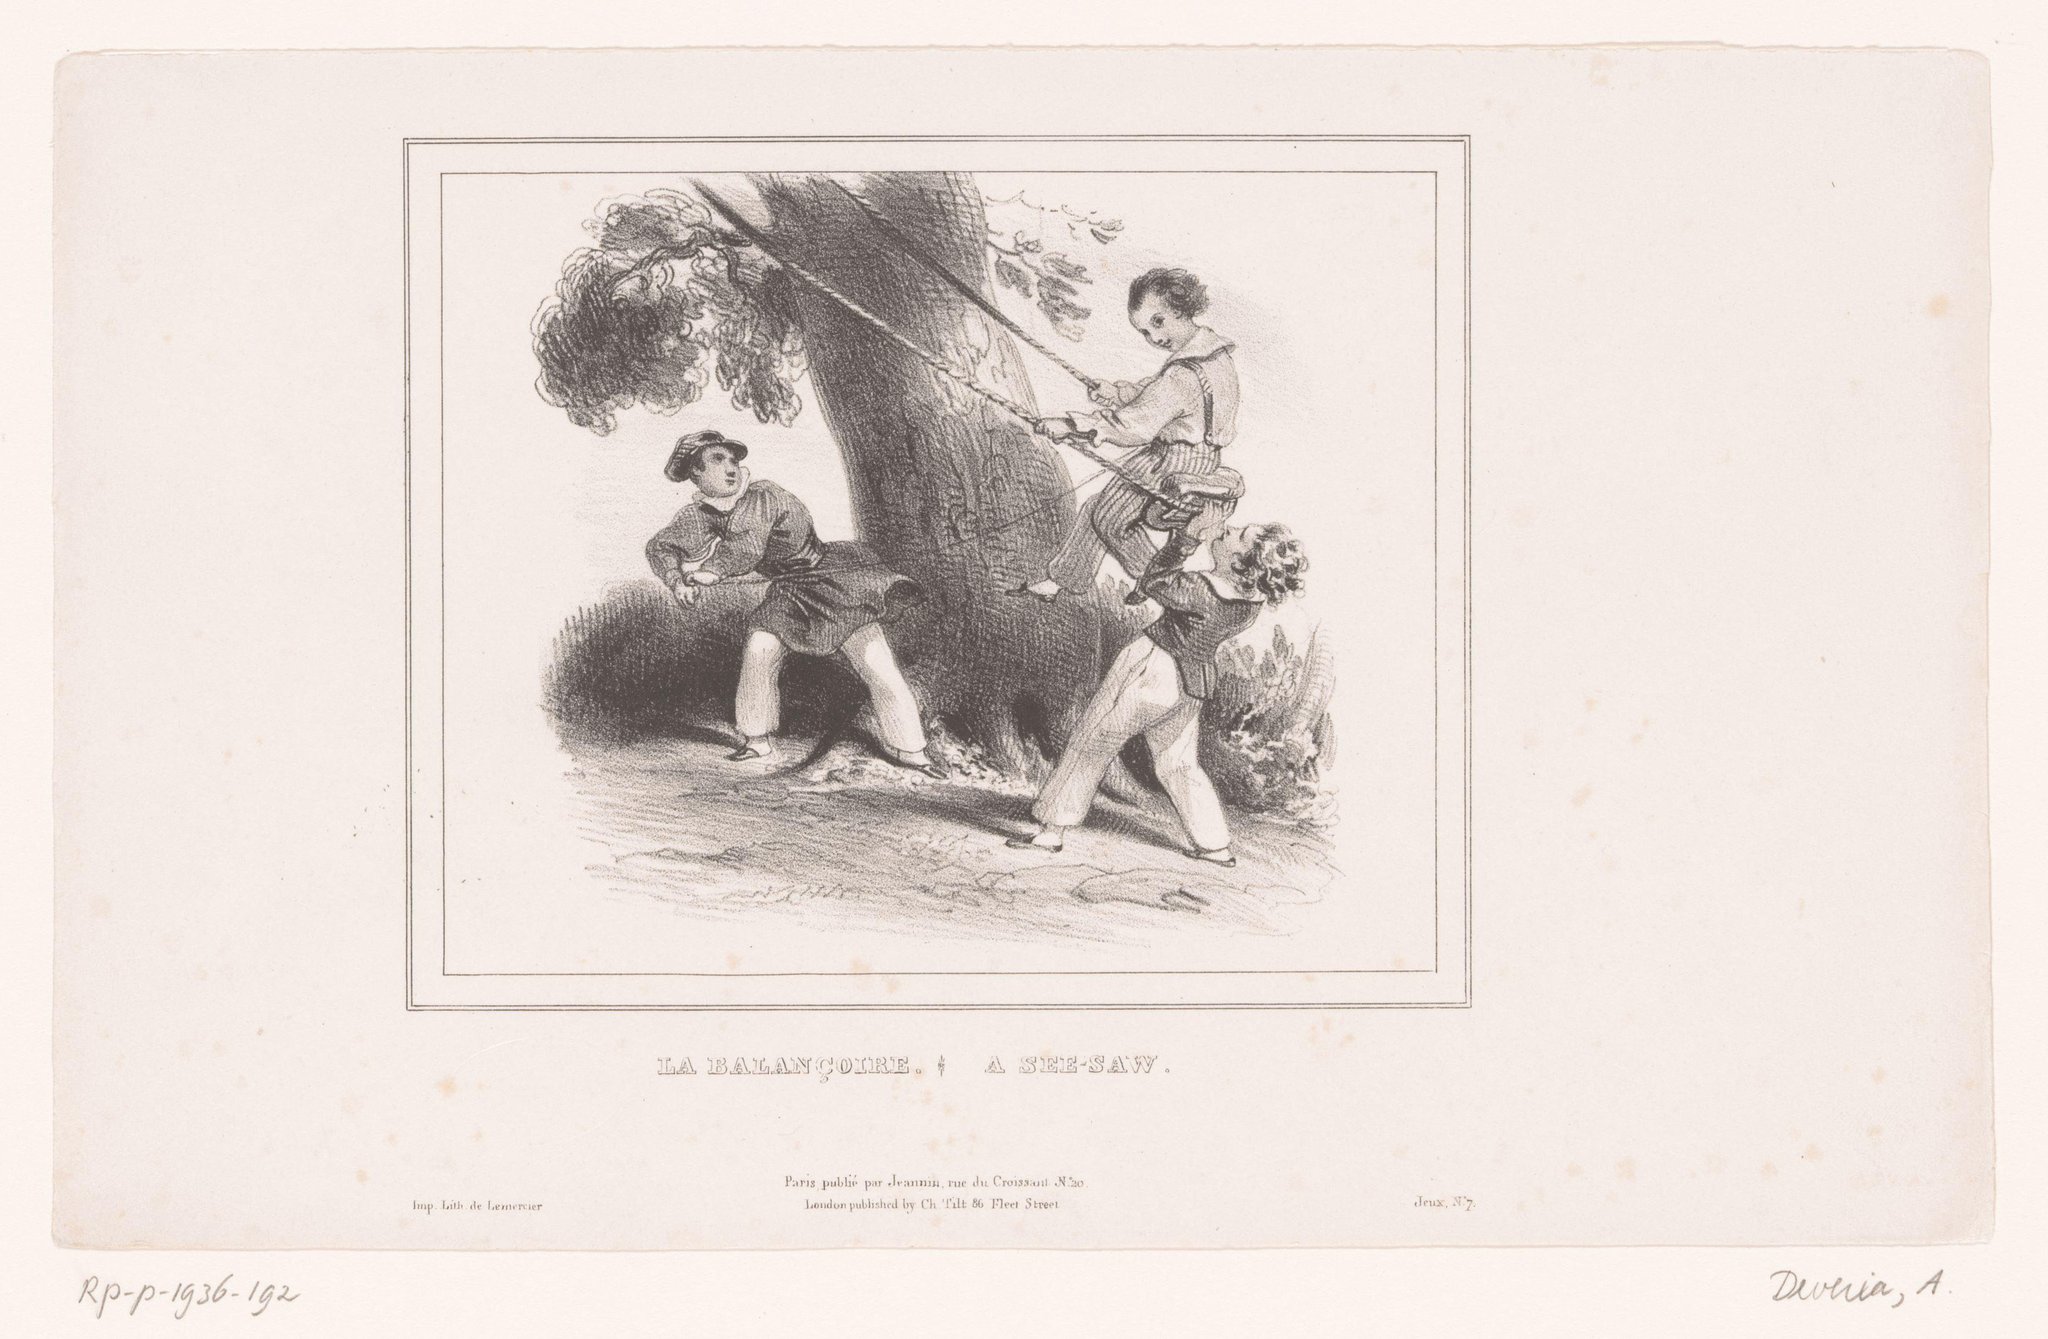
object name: print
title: Drie jongens spelen met een schommel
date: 1832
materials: paper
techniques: lithograph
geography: paris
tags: boy (child between toddler and youth), swinging (children's game), swing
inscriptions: collector's mark: Lugt 2228a, check stamp: Lugt 1397c